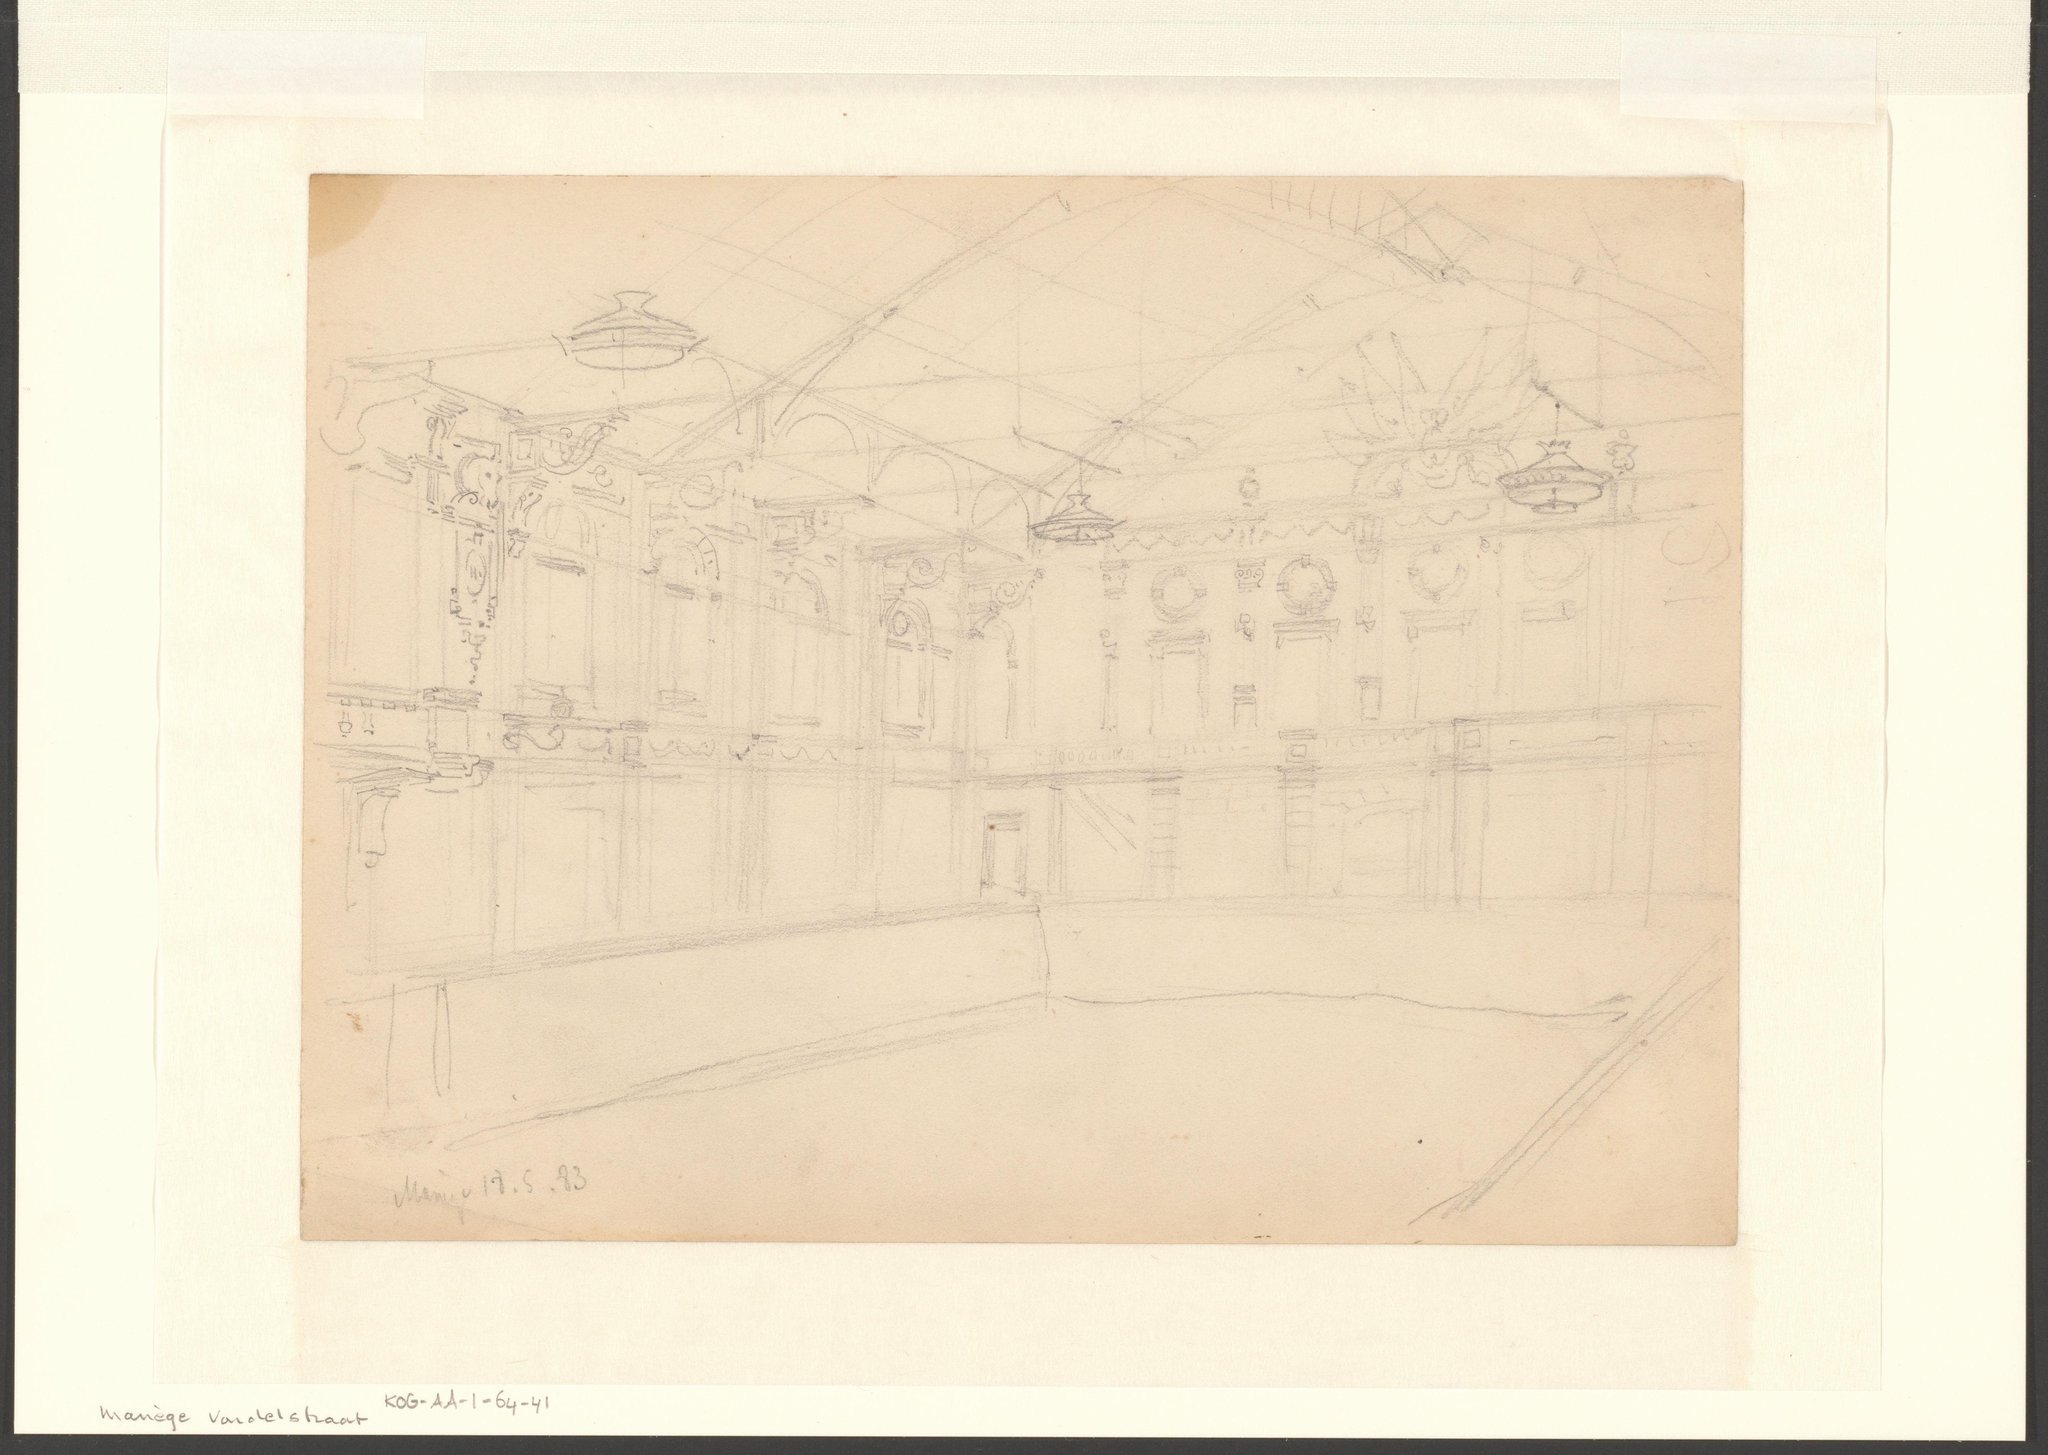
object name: drawing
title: Interieur van de Hollandsche Manege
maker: Anonymous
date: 1883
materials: paper, pencil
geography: amsterdam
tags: riding-school, manège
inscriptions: inscription: ‘manege vondelstraat’, date: ‘Manege 18.5.83’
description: Onderwerpsrubriek binnen de Atlas Amsterdam: Manegegebouwen.